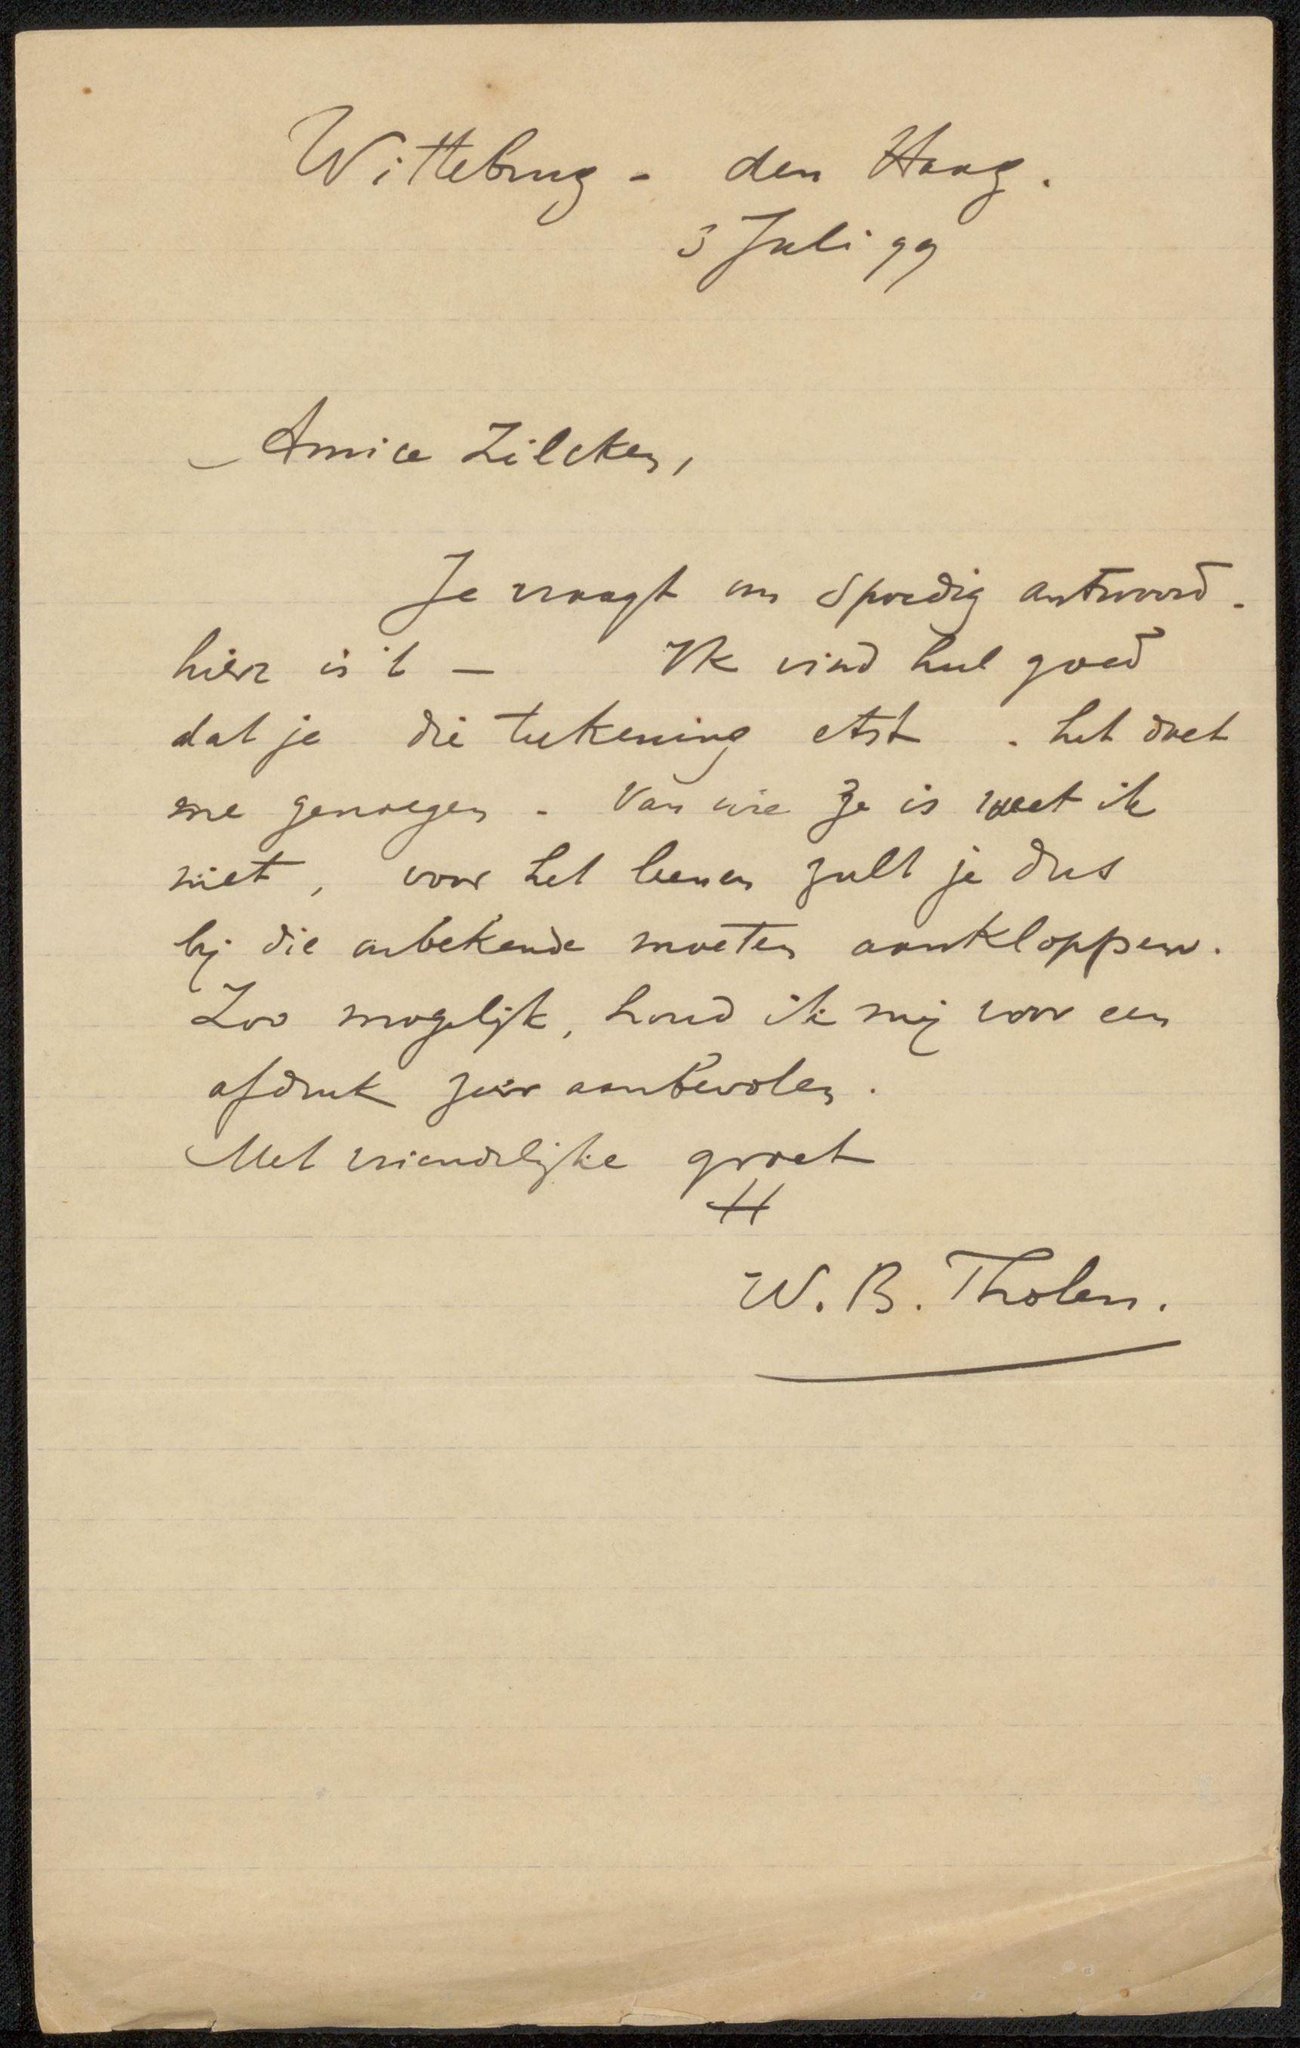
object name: letter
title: Brief aan Philip Zilcken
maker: willem bastiaan tholen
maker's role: draughtsman, painter, print maker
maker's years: 1860-1931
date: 1899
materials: ink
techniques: pen, writing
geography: the hague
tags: the hague, london, painter, print maker, draughtsman, matthijs maris, philip zilcken, drawing, the graphic arts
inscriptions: collector's mark: ‘RPK’